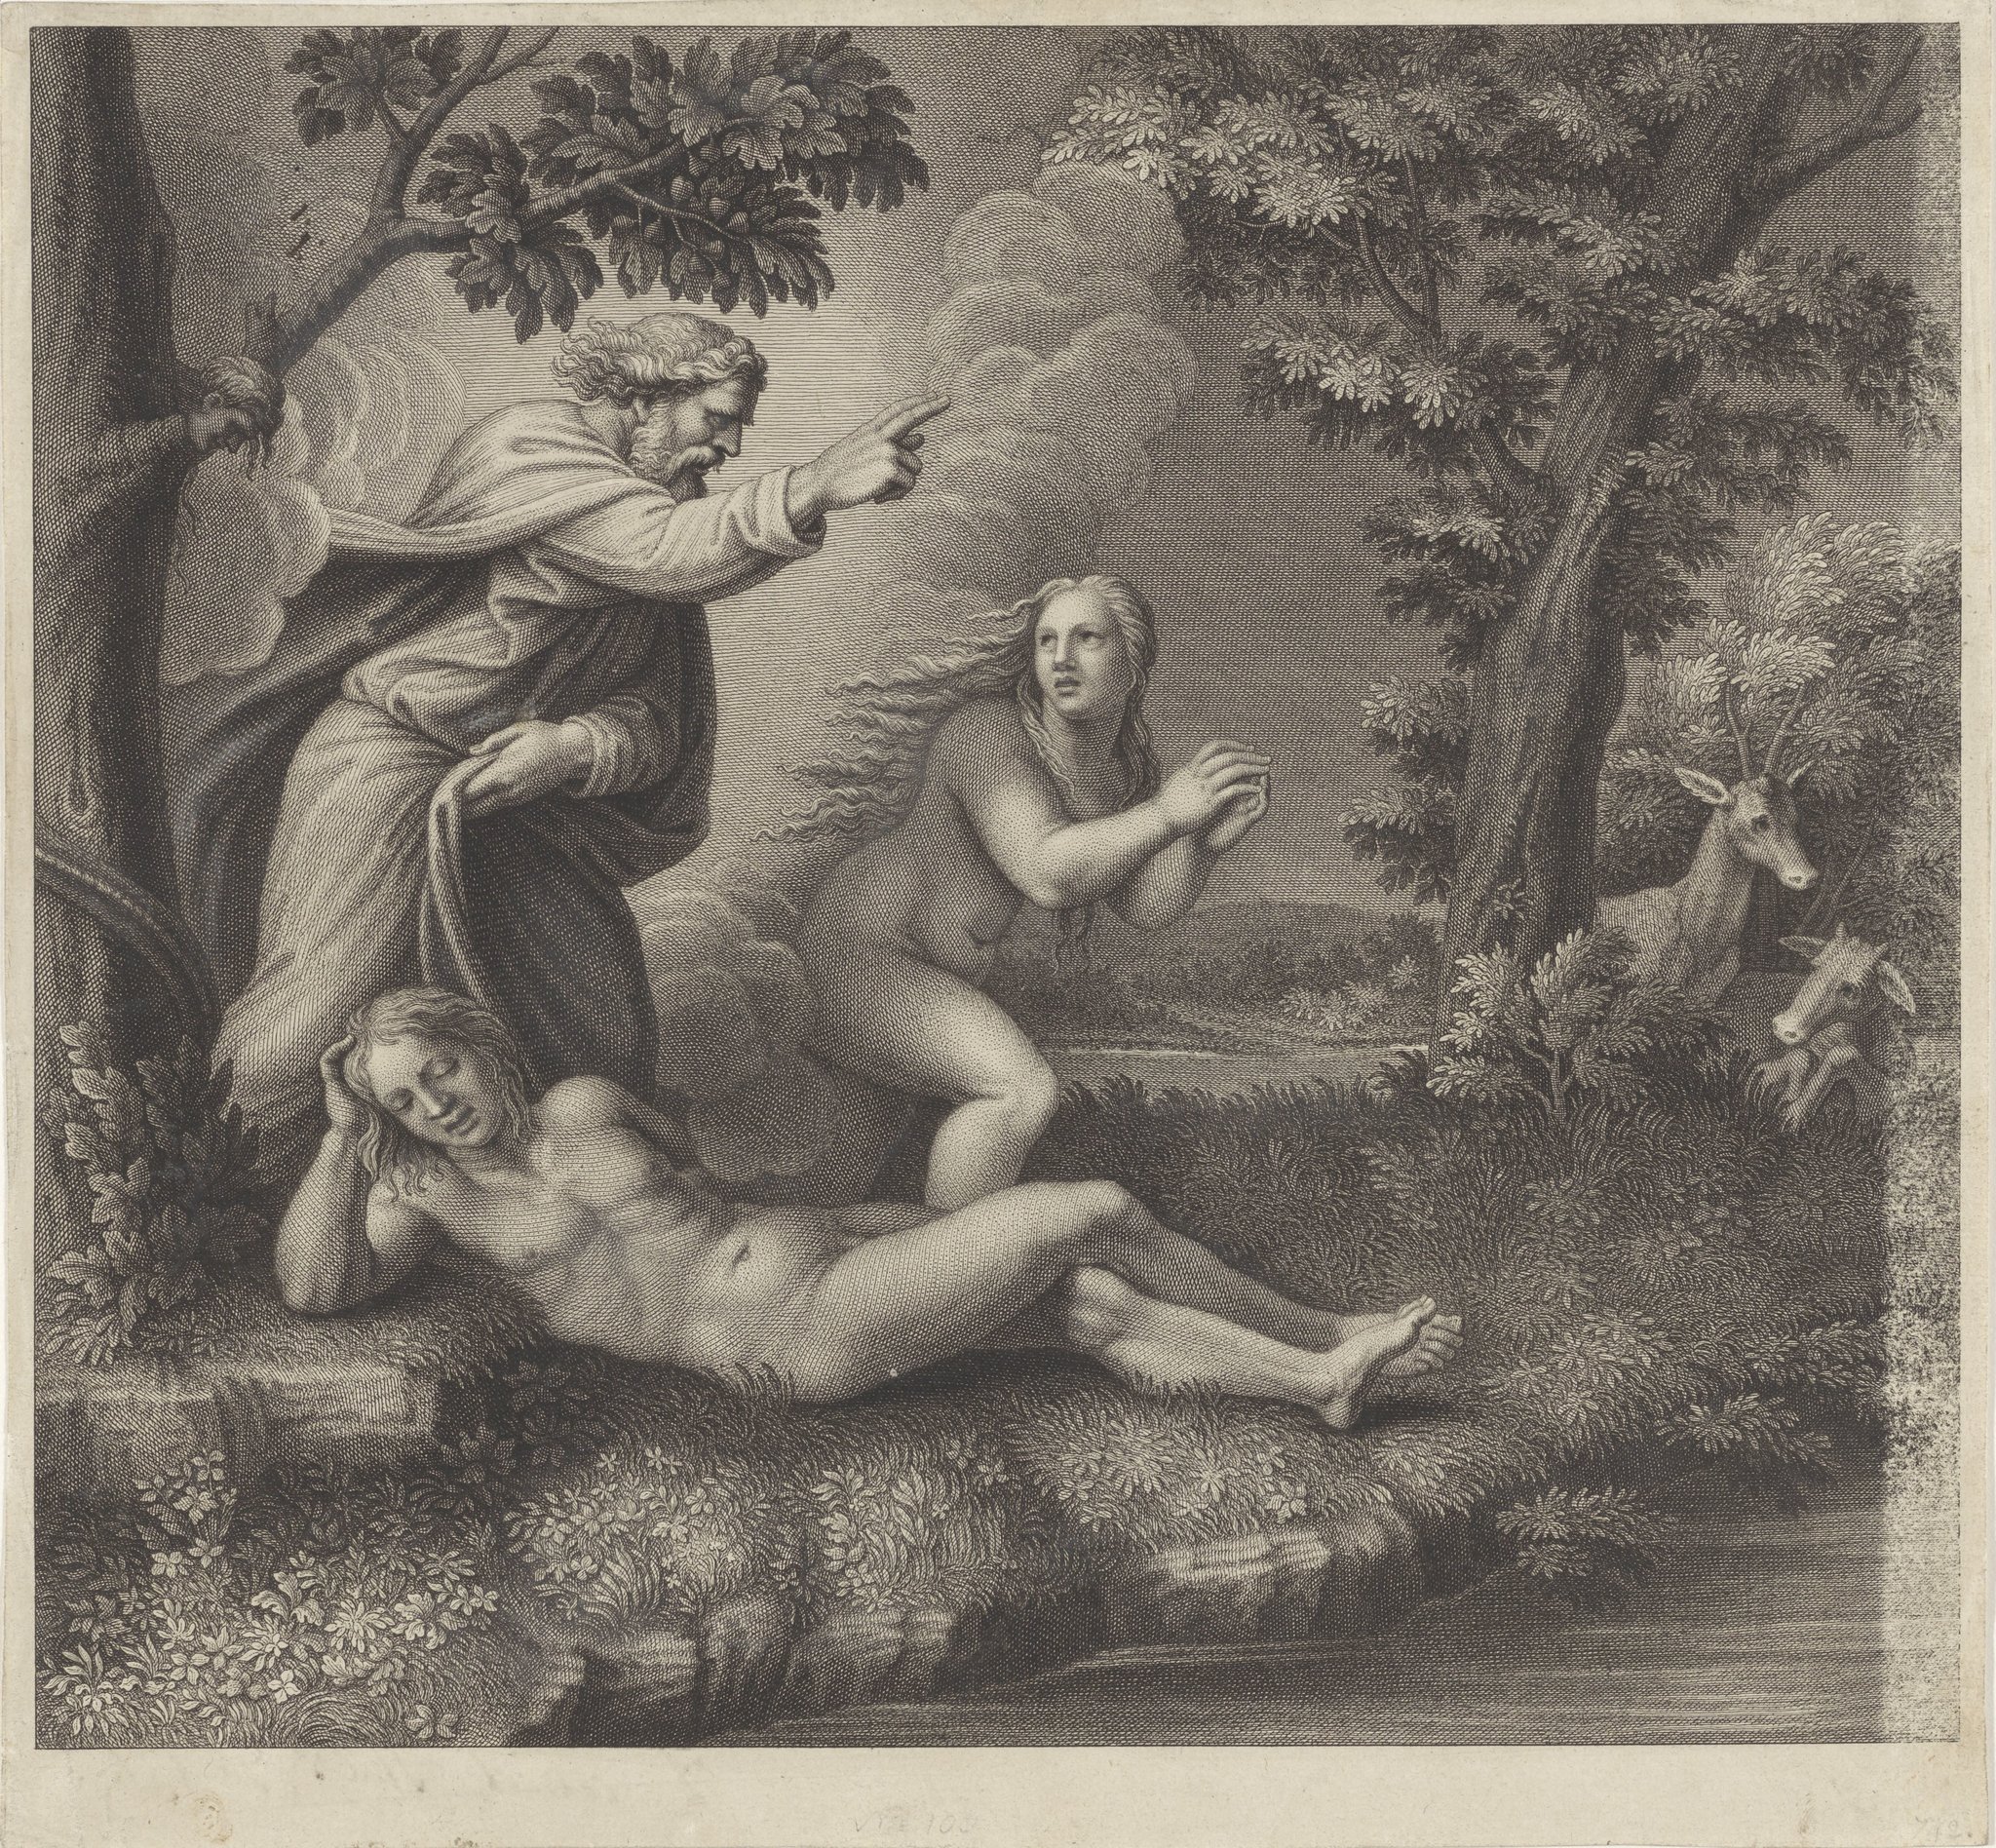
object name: print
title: De schepping van Eva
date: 1745-1788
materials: paper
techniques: engraving, etching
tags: creation of eve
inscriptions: collector's mark: Lugt 240, number: ‘No. 100’, inscription: ‘[...] 1772’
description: God schept Eva uit de rib van de liggende Adam.